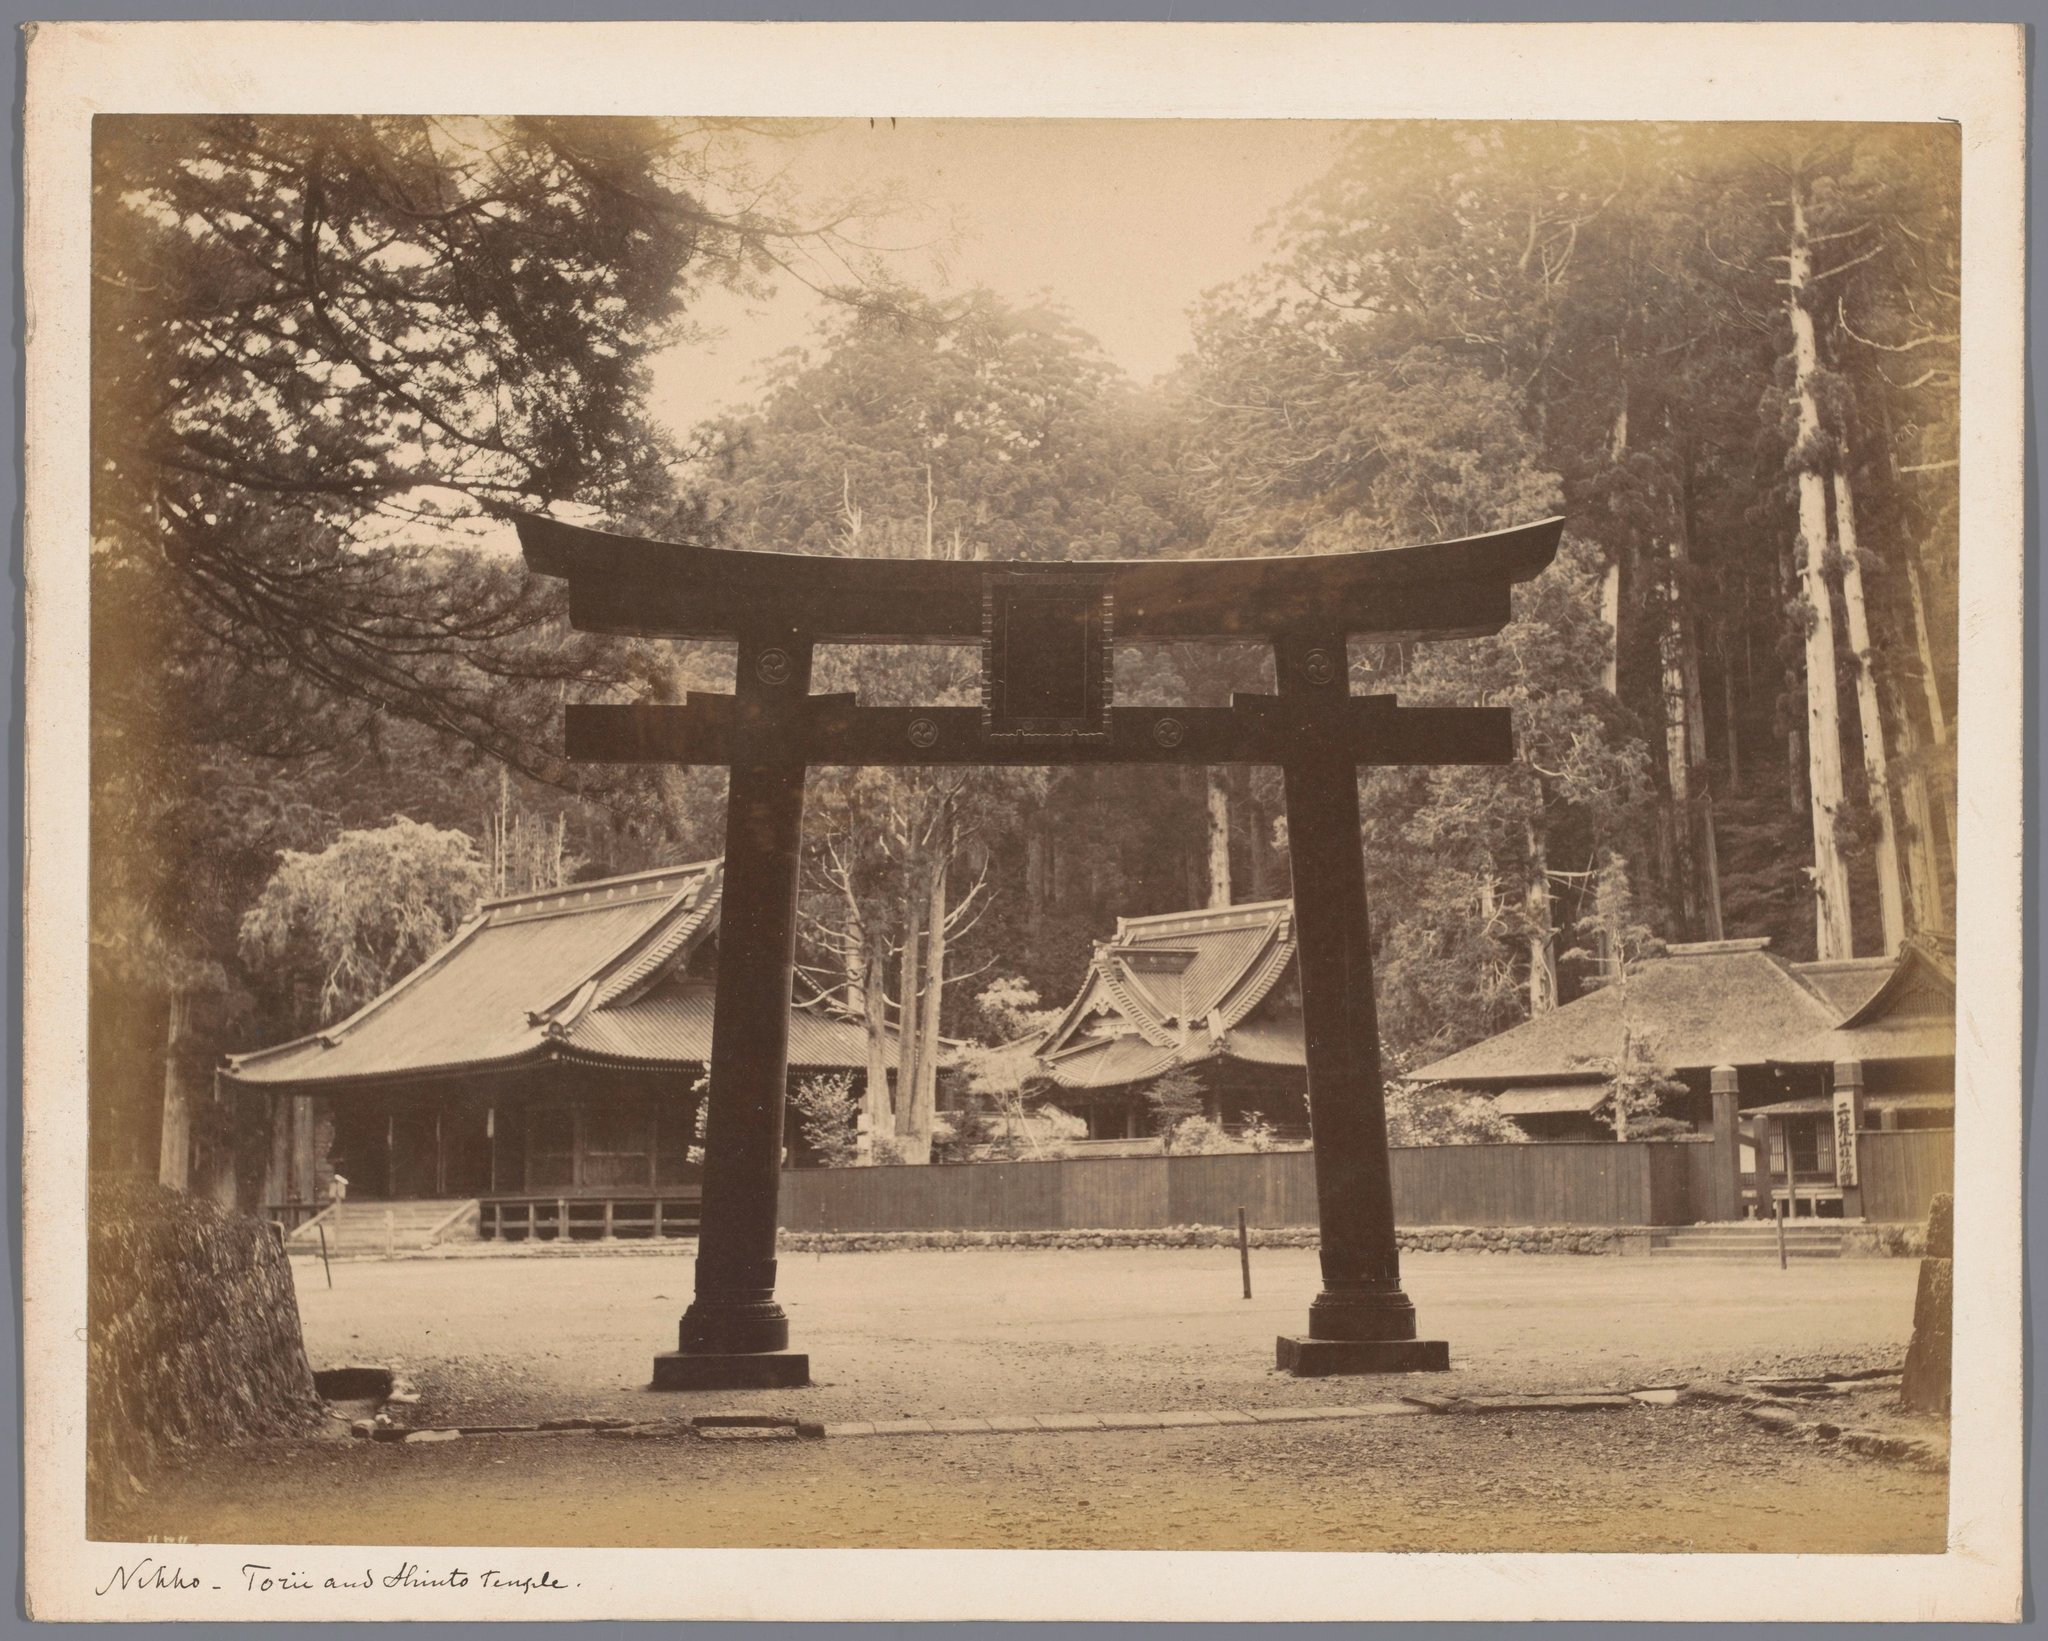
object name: photograph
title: Nikko, torii and Shinto temple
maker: Anonymous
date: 1860-1900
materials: cardboard, paper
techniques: albumen print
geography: japan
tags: temple, shrine ~ shinto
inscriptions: number: ‘70’